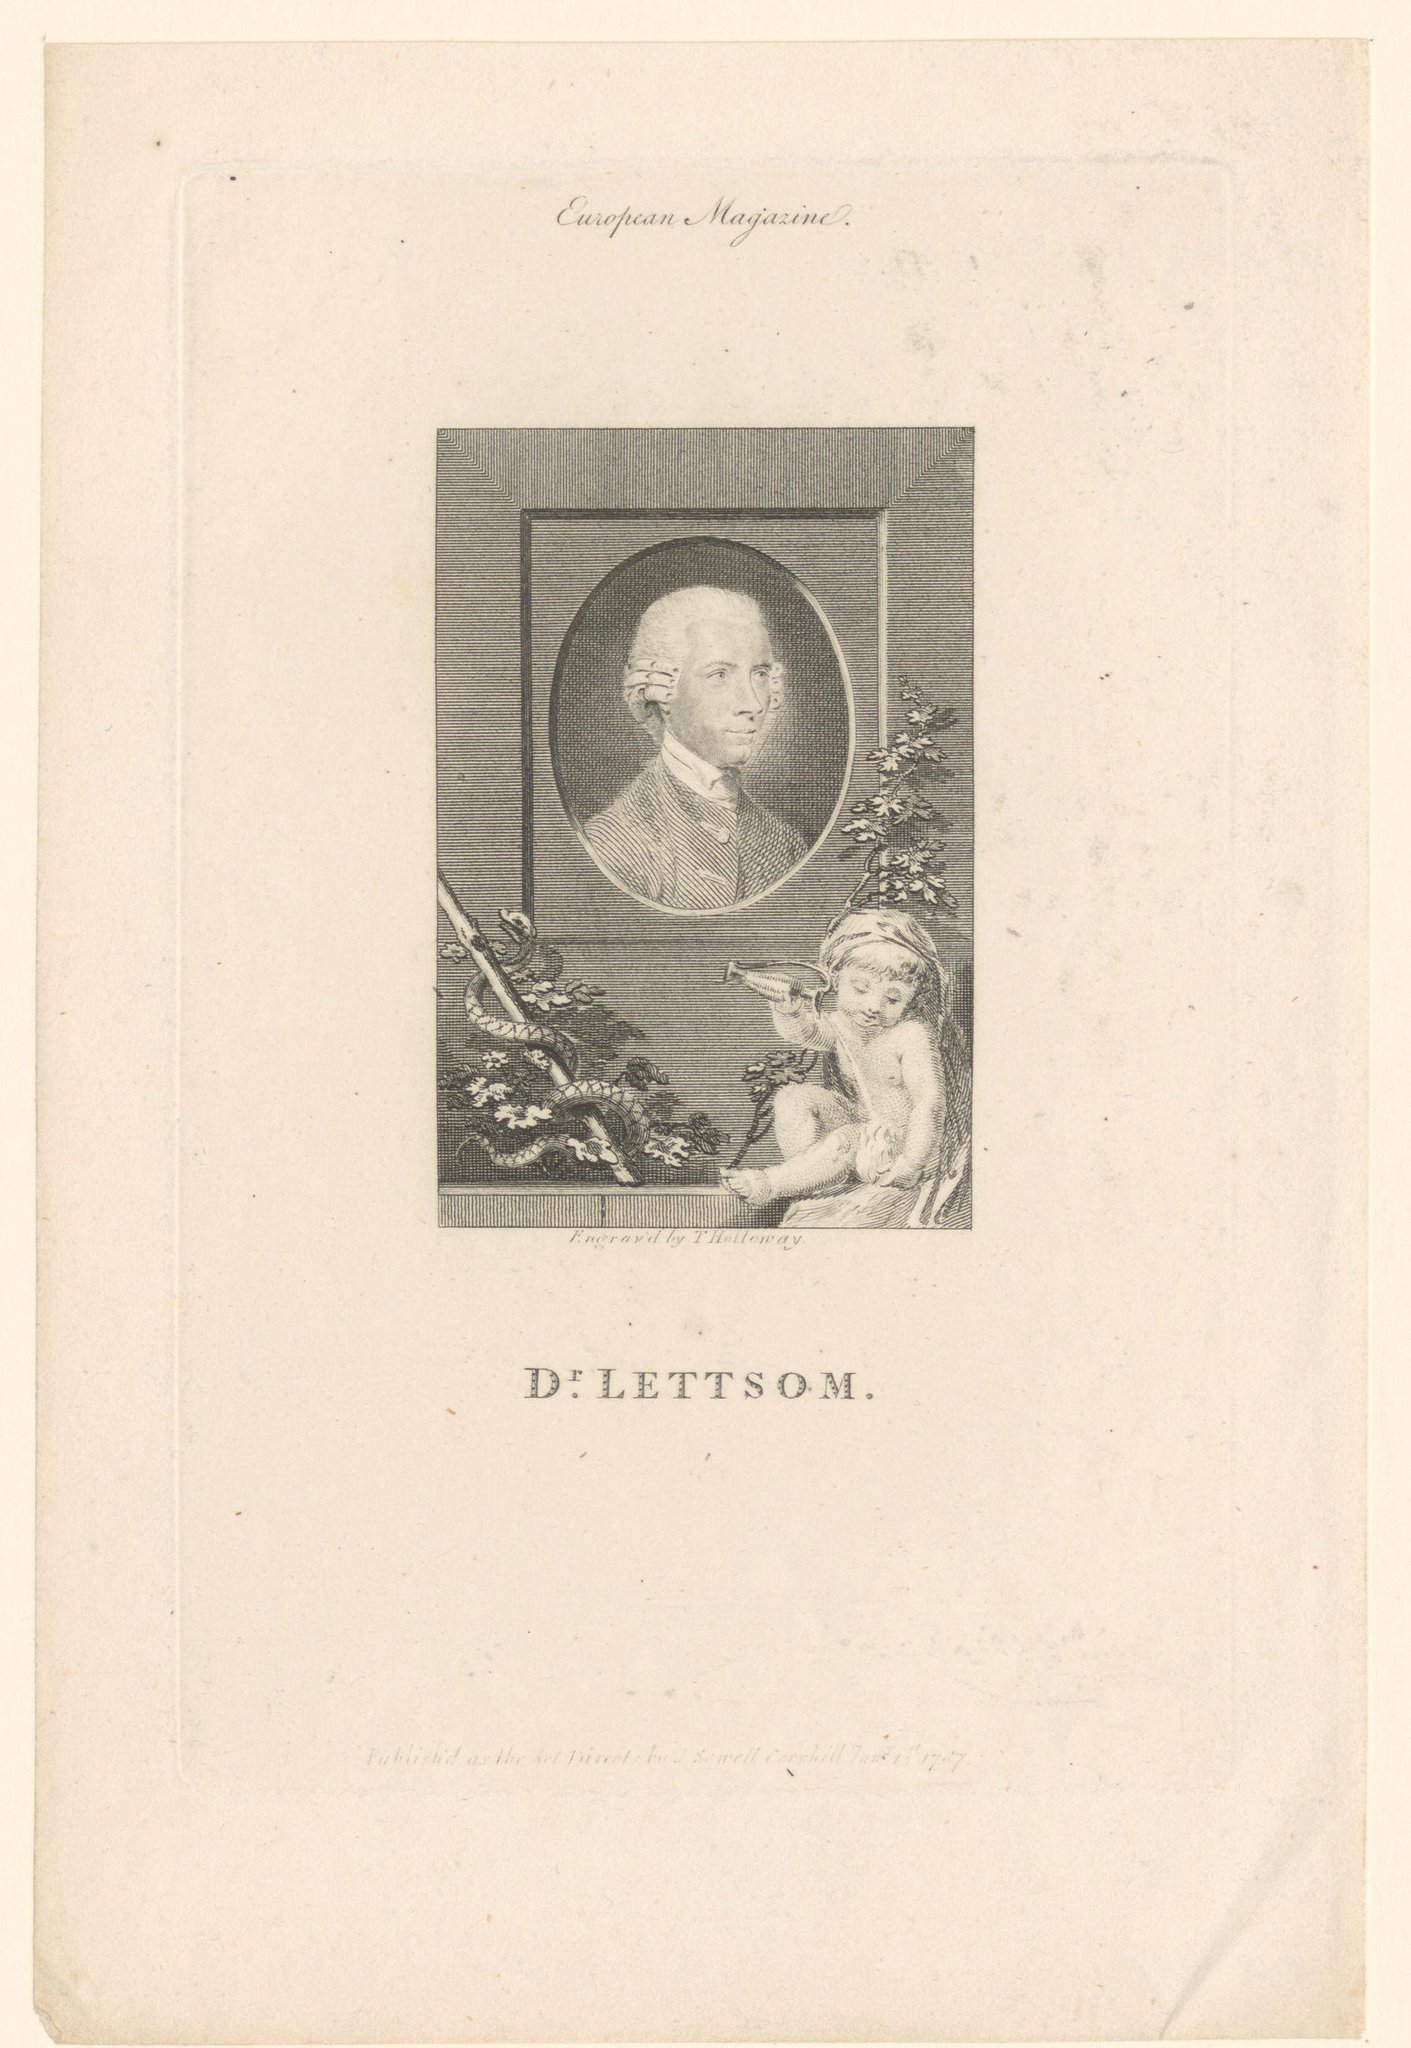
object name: print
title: Portret van John Coakley Lettsom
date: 1787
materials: paper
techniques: etching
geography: london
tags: historical persons, physician, doctor (+ portrait of scholar, scientist)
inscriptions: collector's mark: Lugt 2228